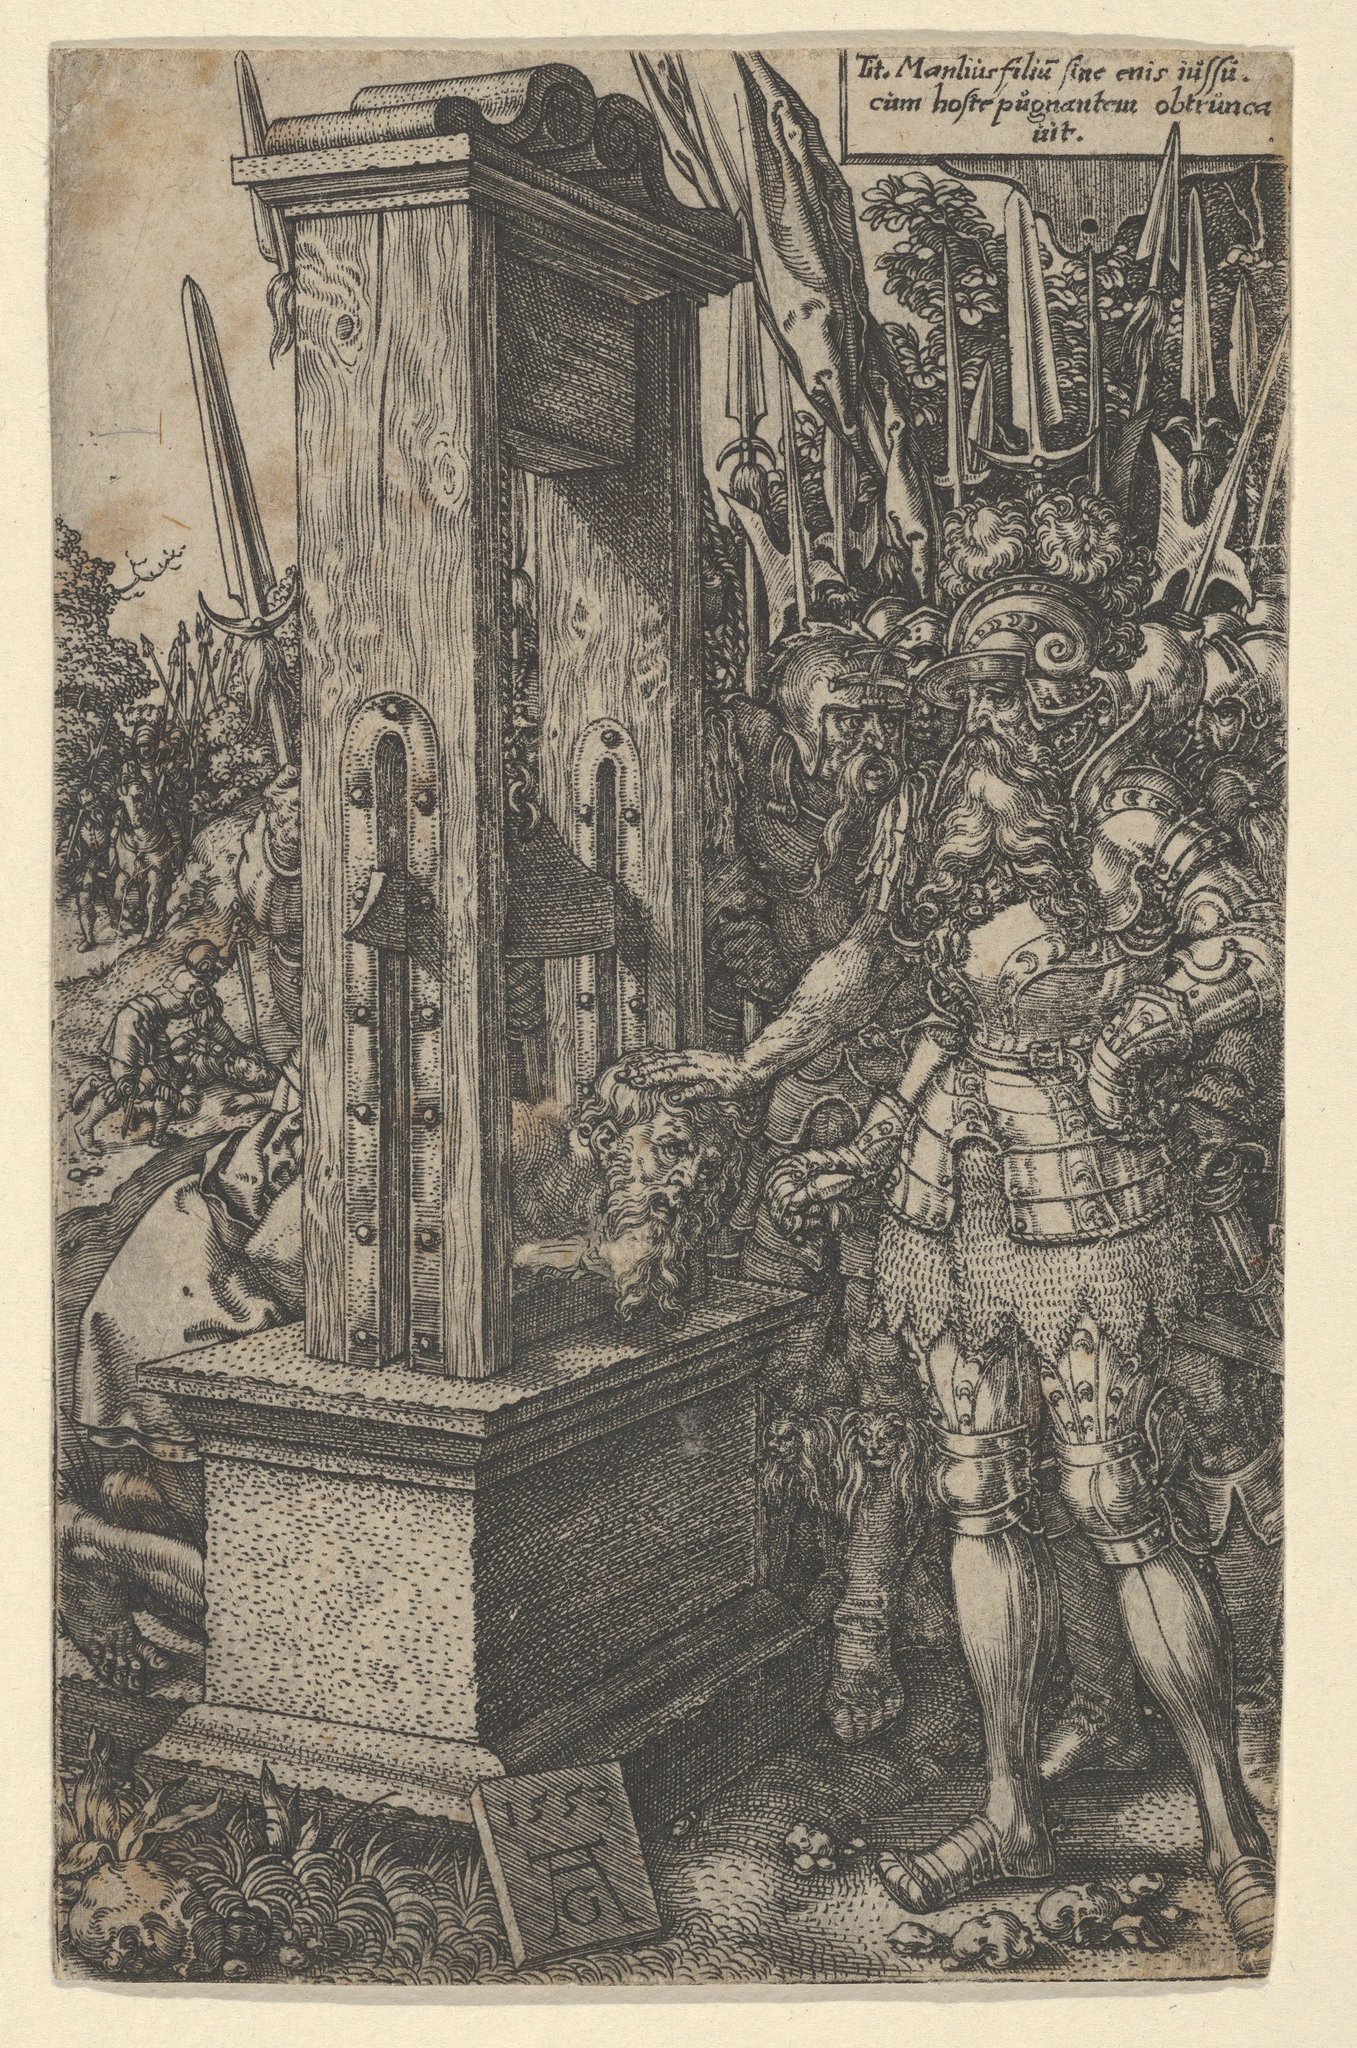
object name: print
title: Titus Manlius Torquatus Ordering the Execution of His Son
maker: heinrich aldegrever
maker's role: artist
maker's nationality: german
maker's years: 1502-1561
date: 1553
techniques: engraving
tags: soldiers,men,execution